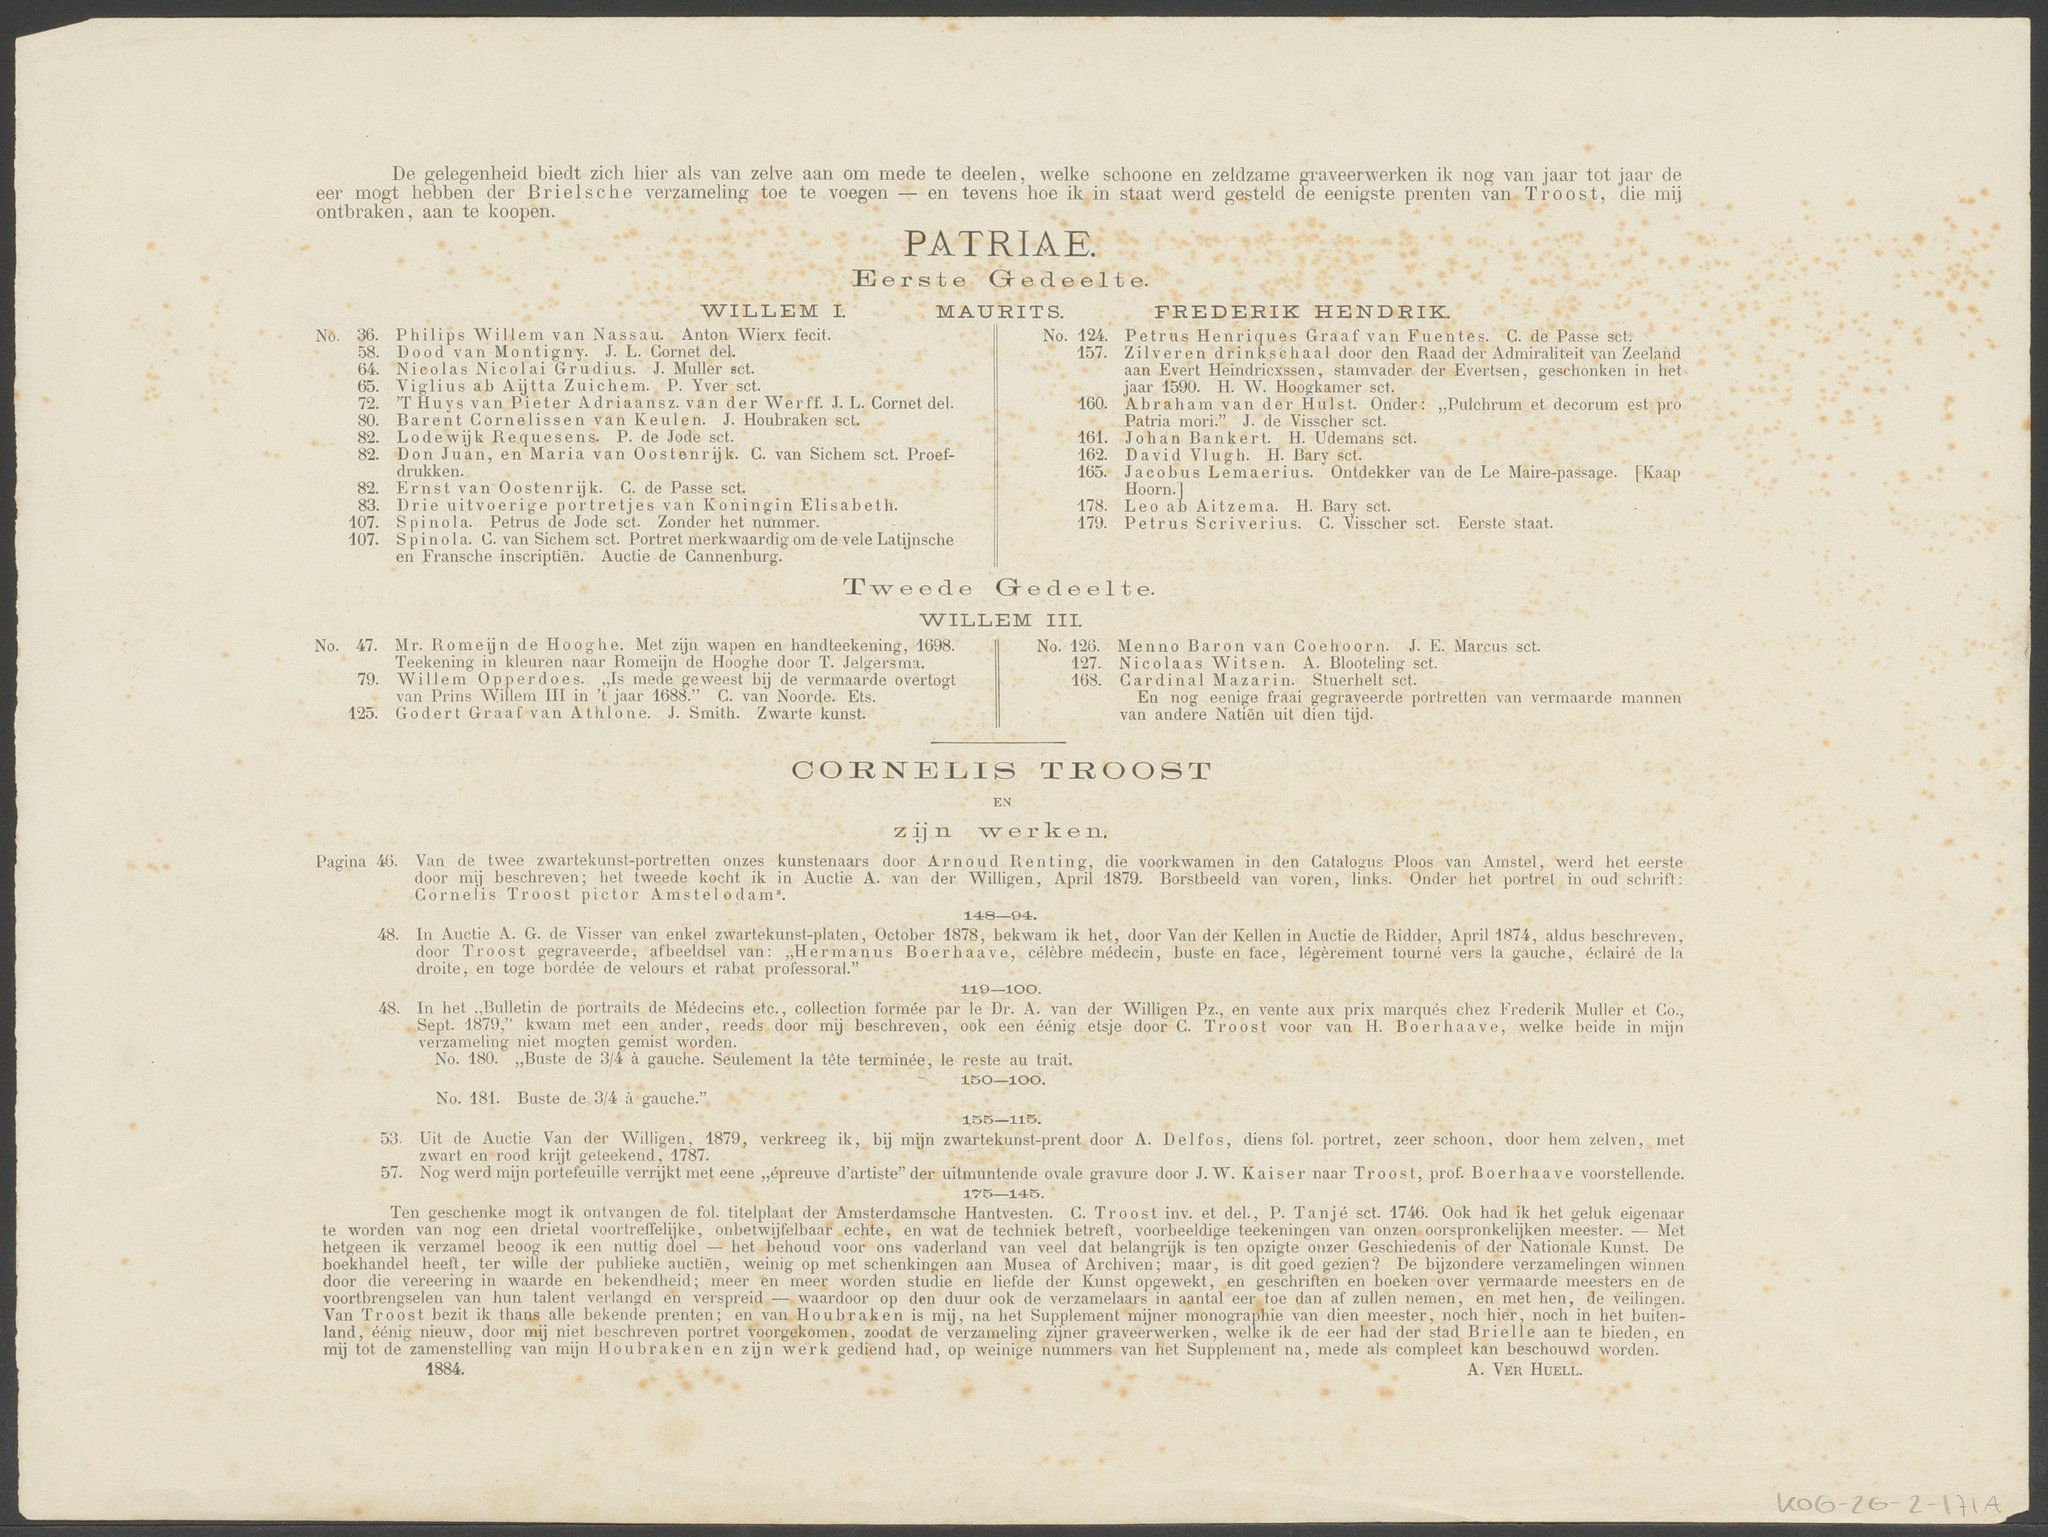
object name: text sheet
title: Tekst door Alexander Ver Huell over een prentcollectie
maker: alexander ver huell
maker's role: draughtsman, print maker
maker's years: 1822-1897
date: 1884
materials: paper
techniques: letterpress printing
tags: arnhem, print maker, draughtsman, alexander ver huell, brielle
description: Tekst door Alexander Ver Huell over prentcollecties. Recto: overzicht prenten 'Patriae' voor de 'Brielsche verzameling' en ontbrekende prenten van Cornelis Troost. Verso: een verhaal over de 'Transvaalsche Tentoonstelling' in Amsterdam in 1883. Tekstblad bedrukt op beide zijden.